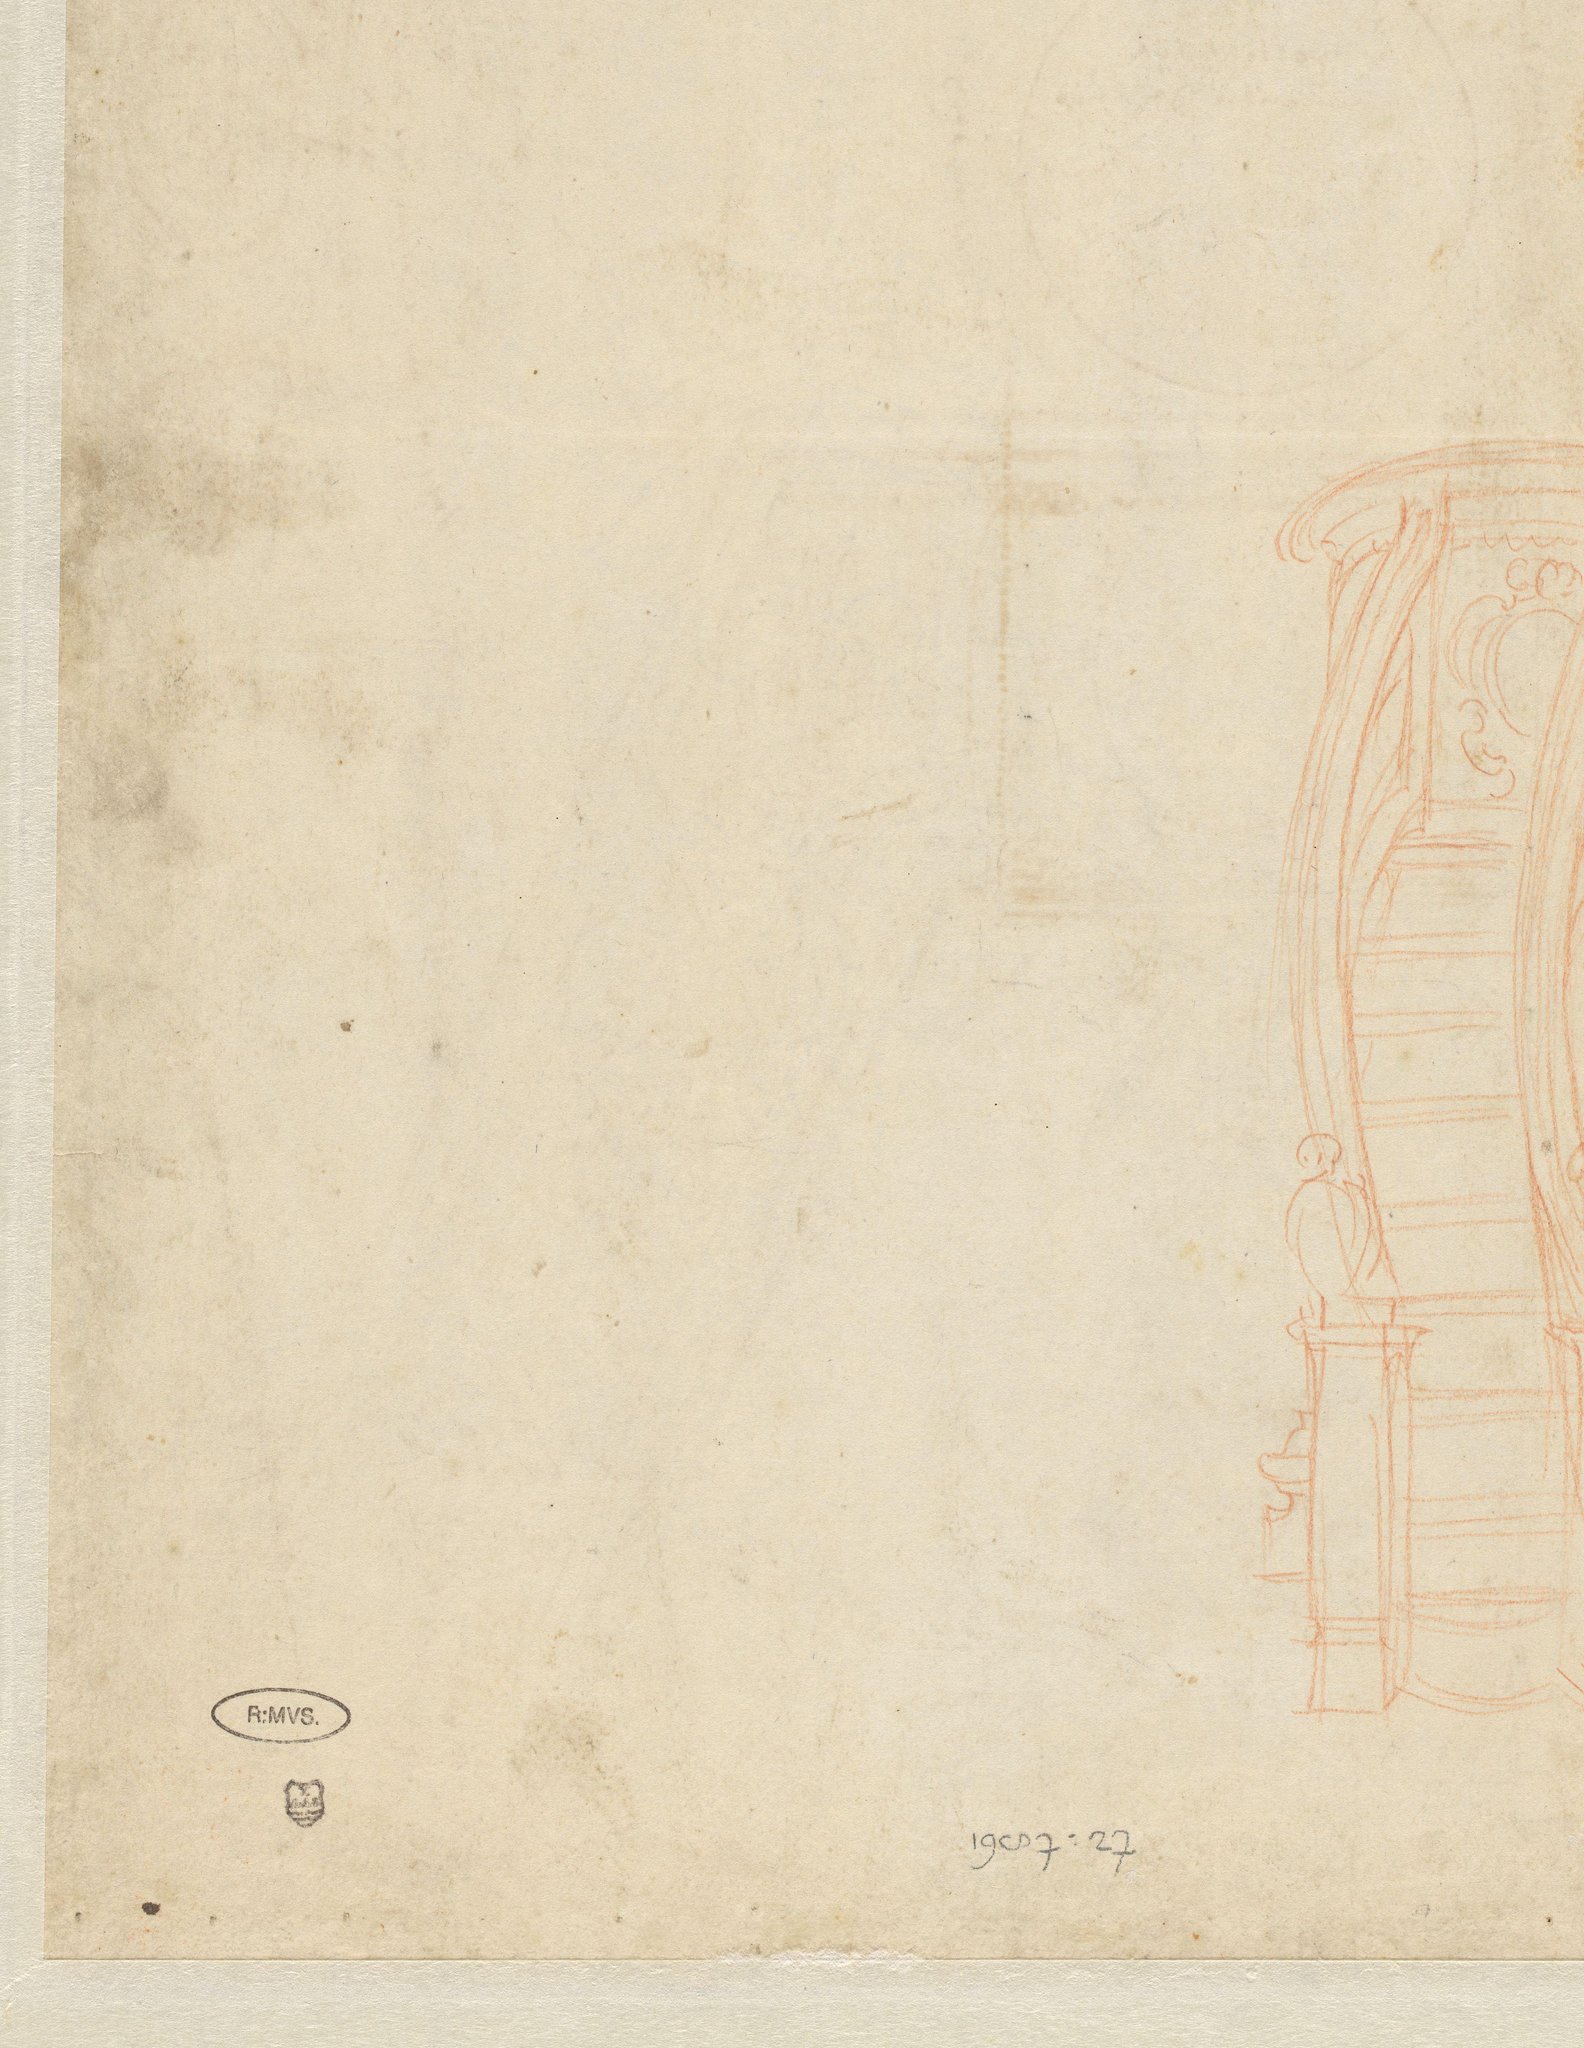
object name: drawing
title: Schets voor de trap van een preekstoel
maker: jan claudius de cock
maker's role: draughtsman, print maker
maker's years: 1668-1736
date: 1678-1736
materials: chalk, paper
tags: pulpit, ambo, chancel